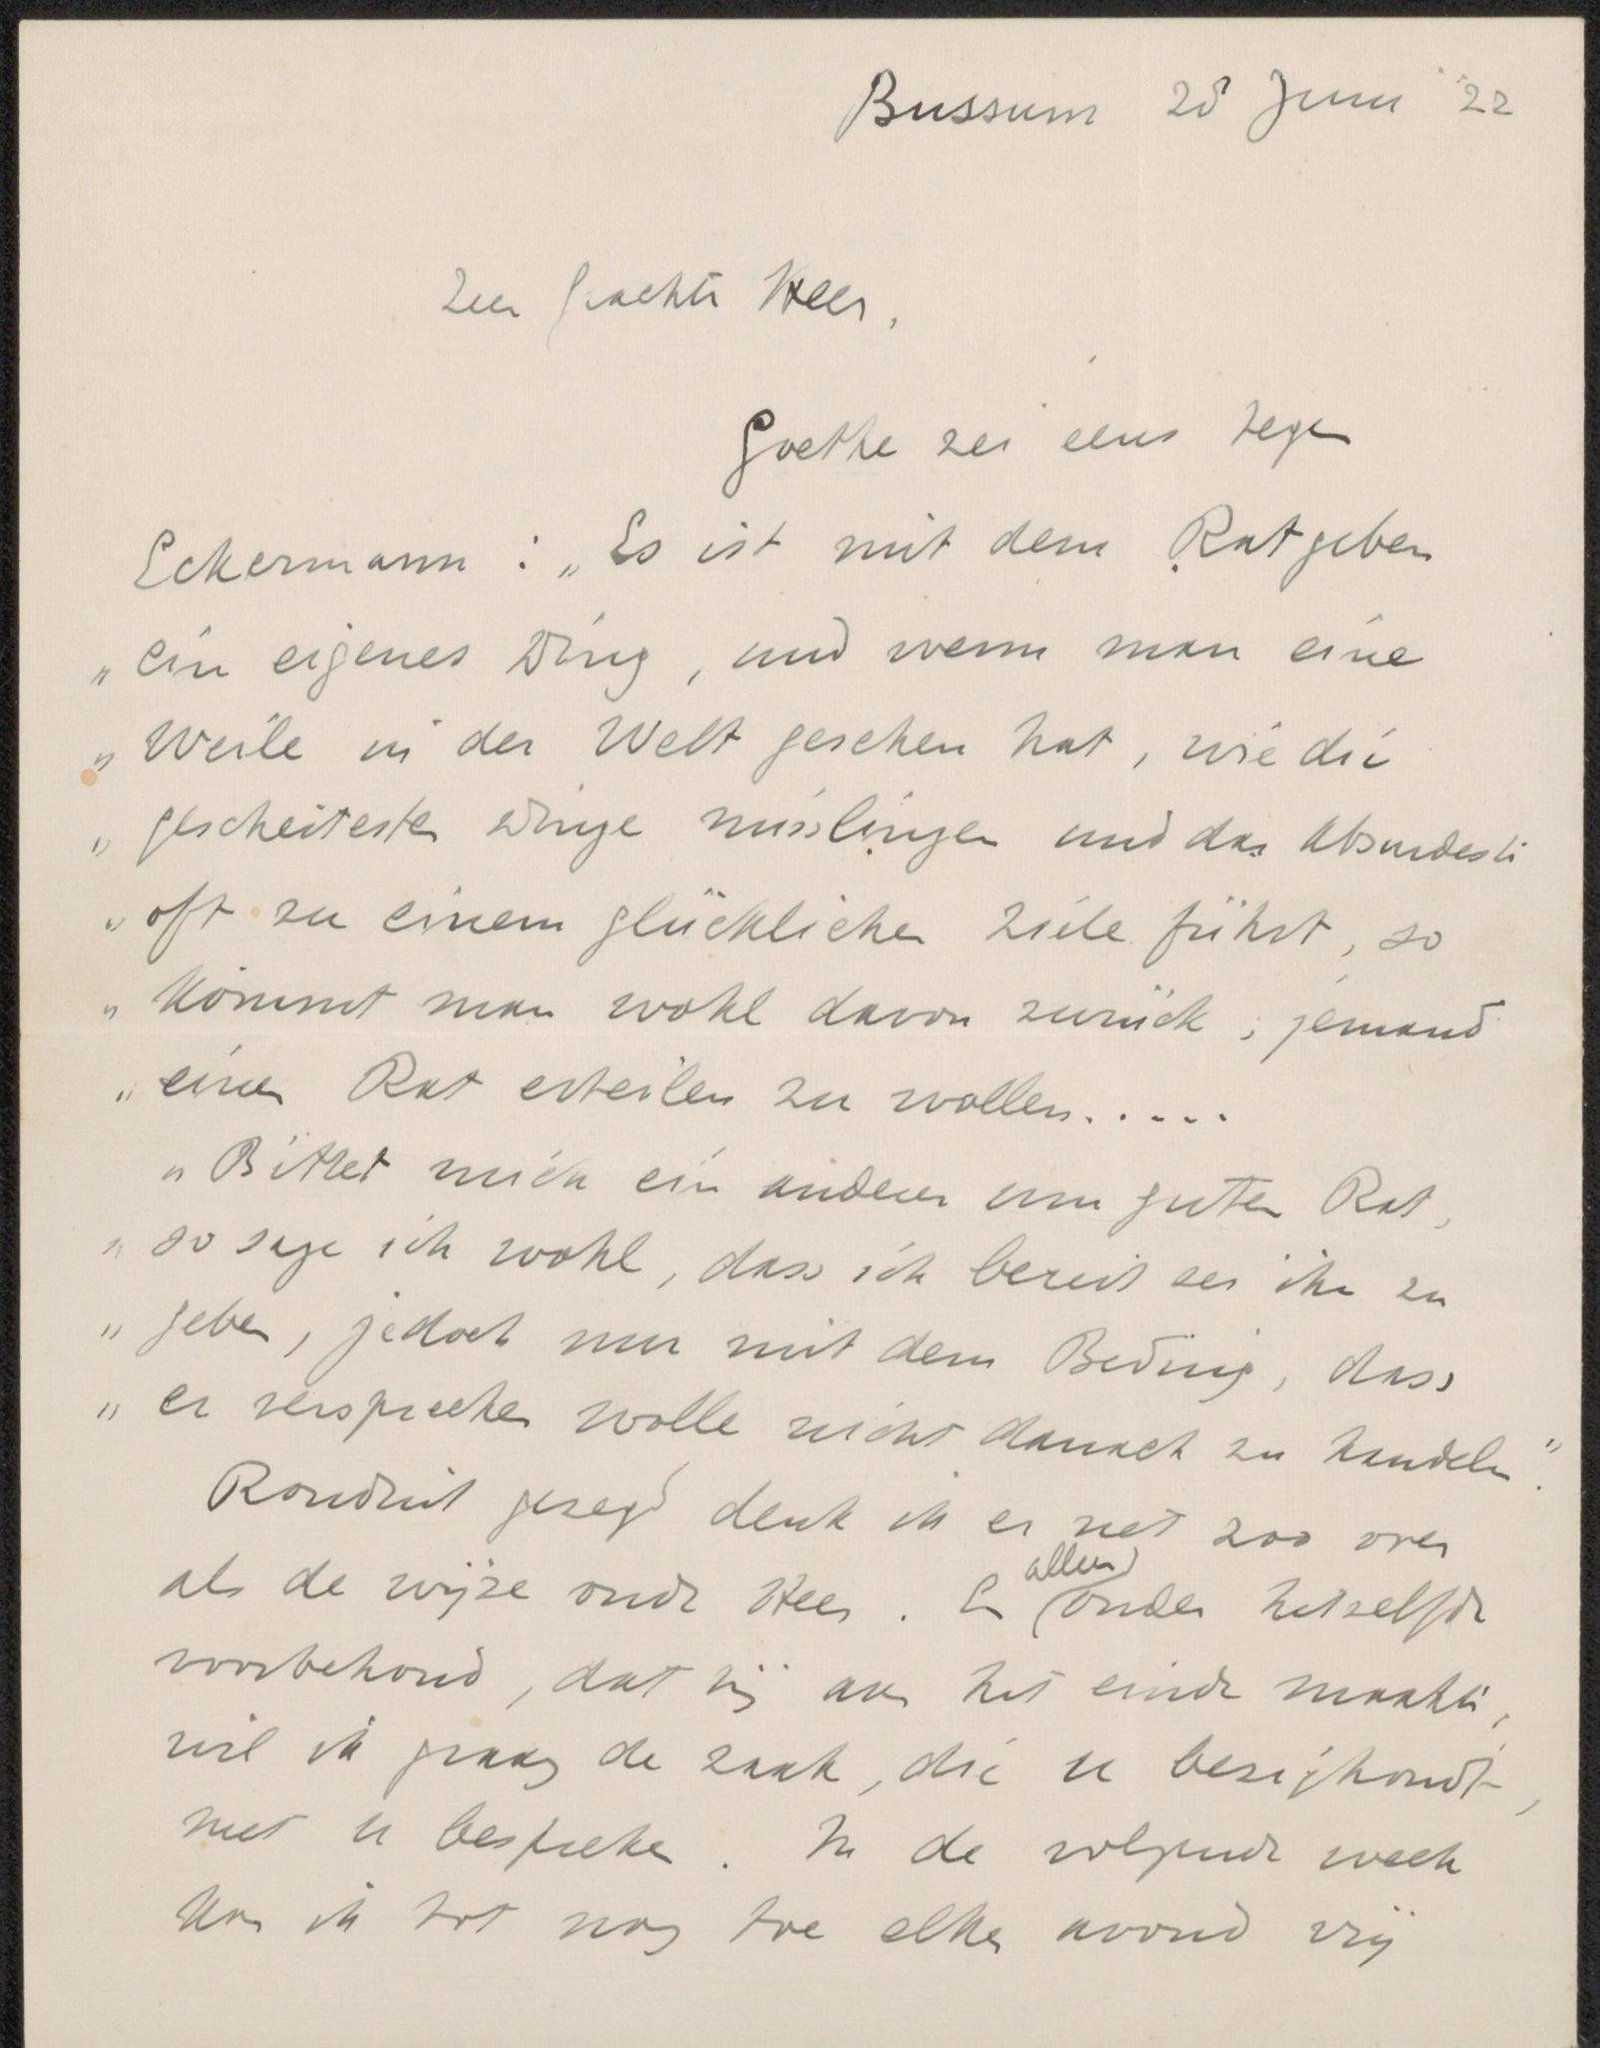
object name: letter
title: Brief aan F.E. Posthumus Meyjes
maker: jan veth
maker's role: designer, draughtsman, painter, print maker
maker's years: 1864-1925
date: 1922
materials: ink, paper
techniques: pen, writing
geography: bussum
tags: f.e. posthumus meyjes, draughtsman, johann wolfgang von goethe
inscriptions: watermark, collector's mark: ‘RPK’